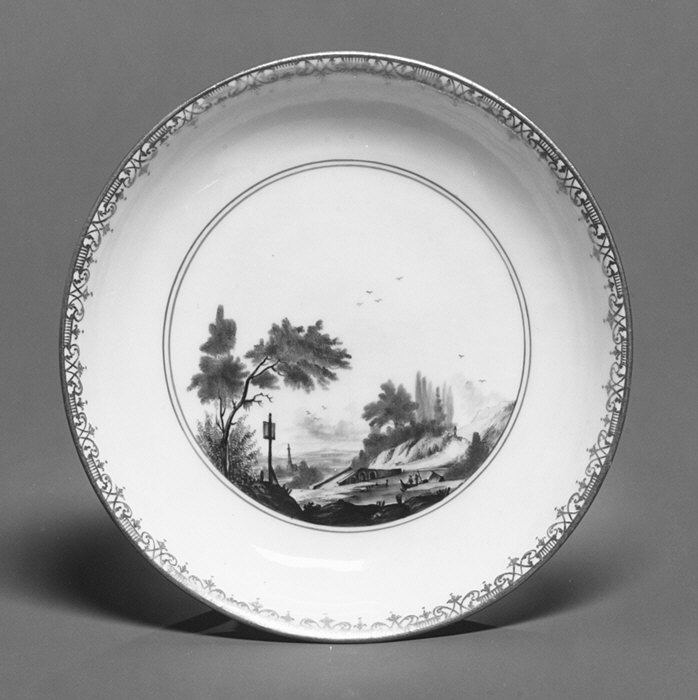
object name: saucer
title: Saucer (part of a service)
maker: meissen manufactory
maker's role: manufactory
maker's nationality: german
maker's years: 1710-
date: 1701-1800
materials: hard paste porcelain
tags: landscapes,trees